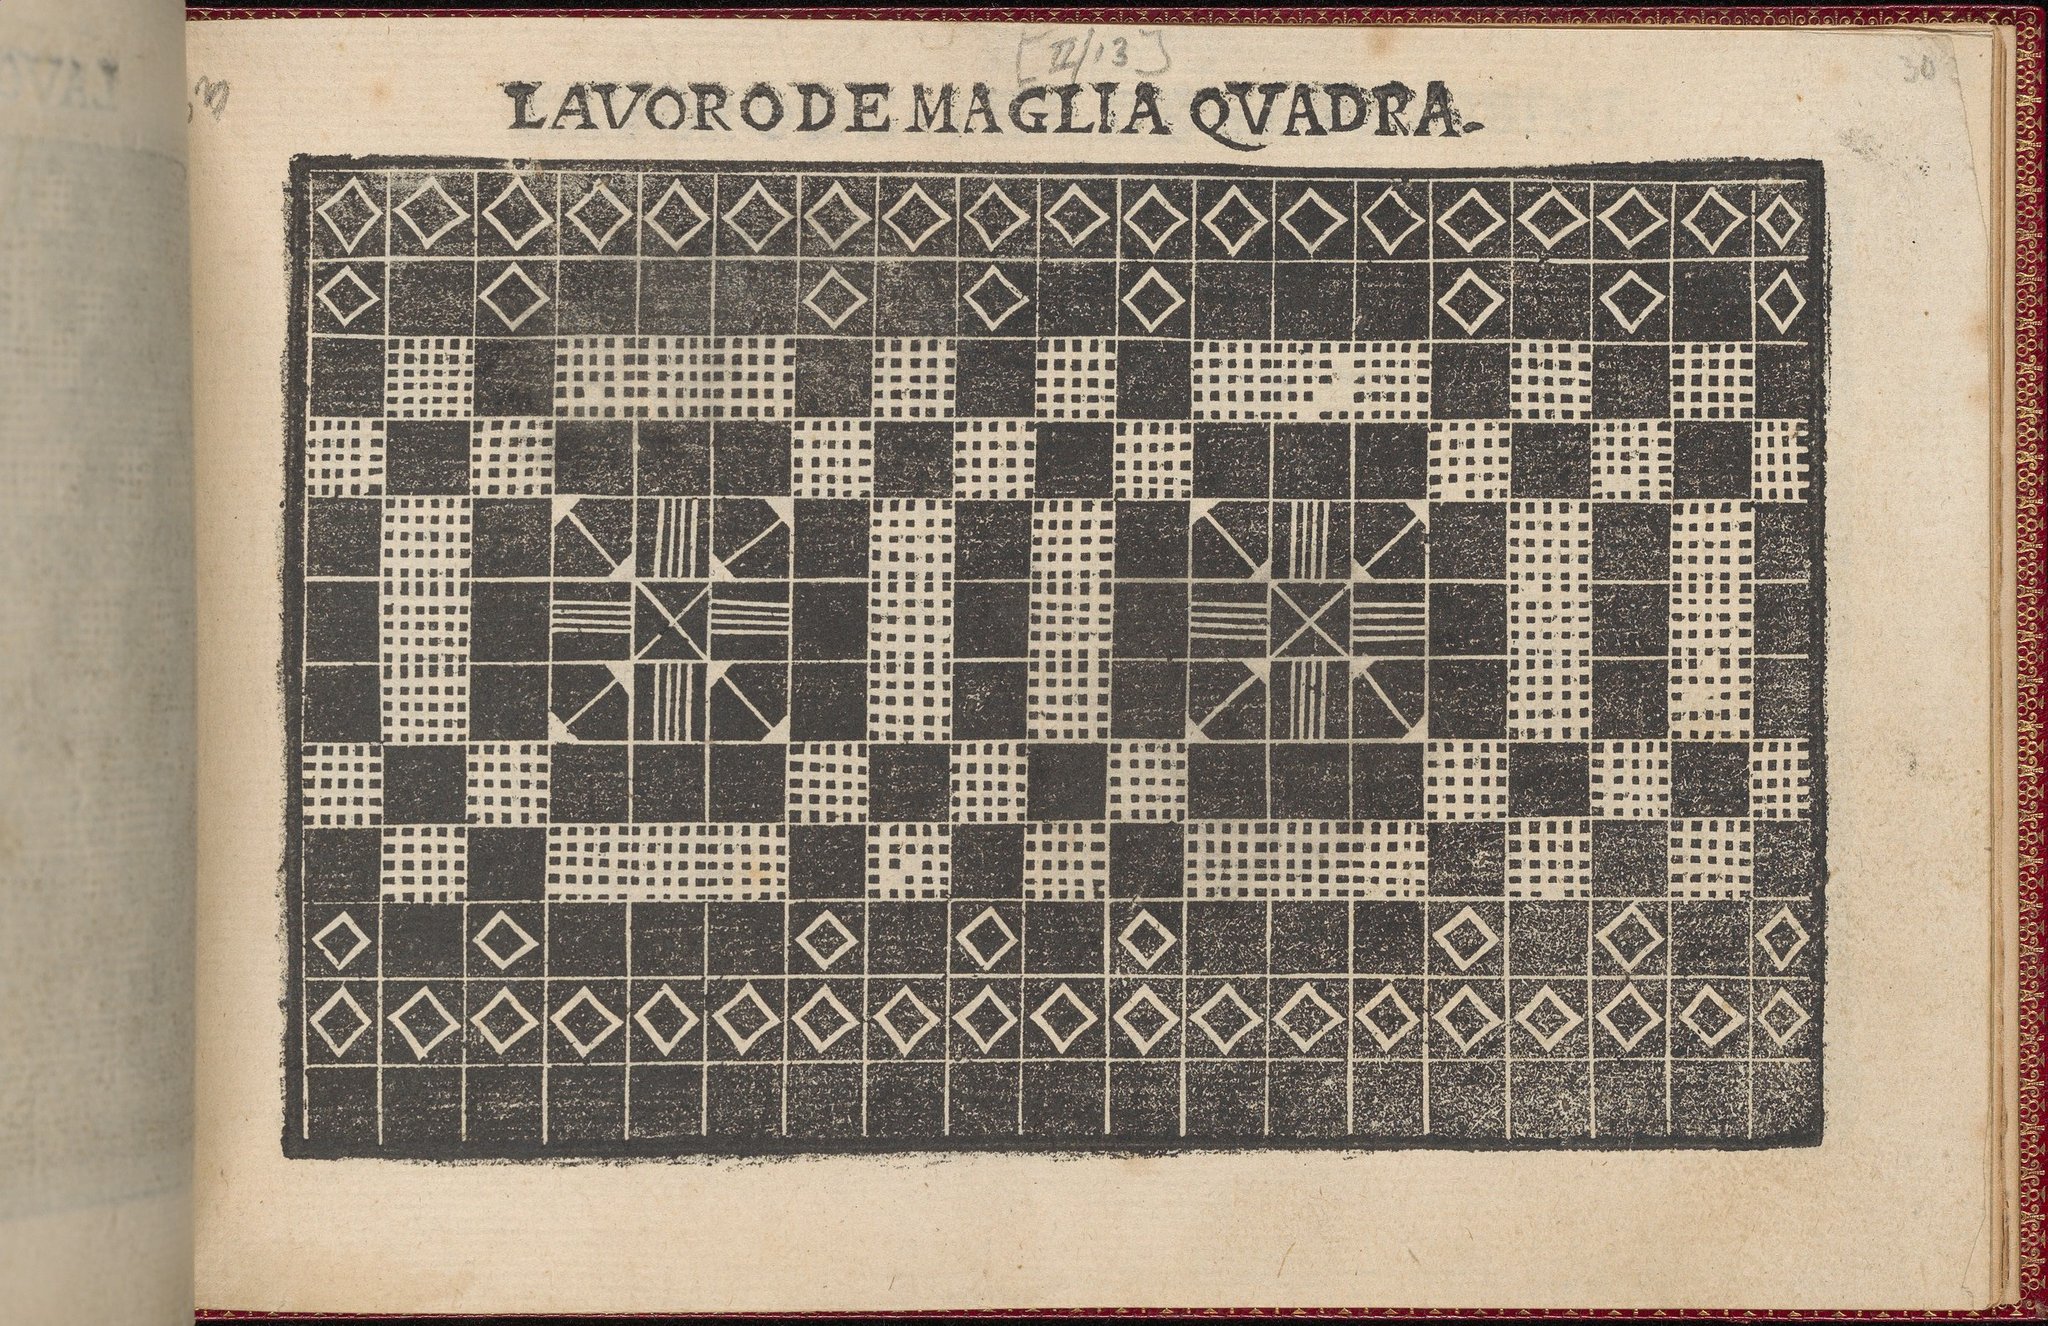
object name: book print ornament architecture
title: Pretiosa Gemma delle virtuose donne, page 32 (recto)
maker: isabella catanea parasole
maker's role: author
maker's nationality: italian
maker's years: 1565-1625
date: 1600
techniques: woodcut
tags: ornament